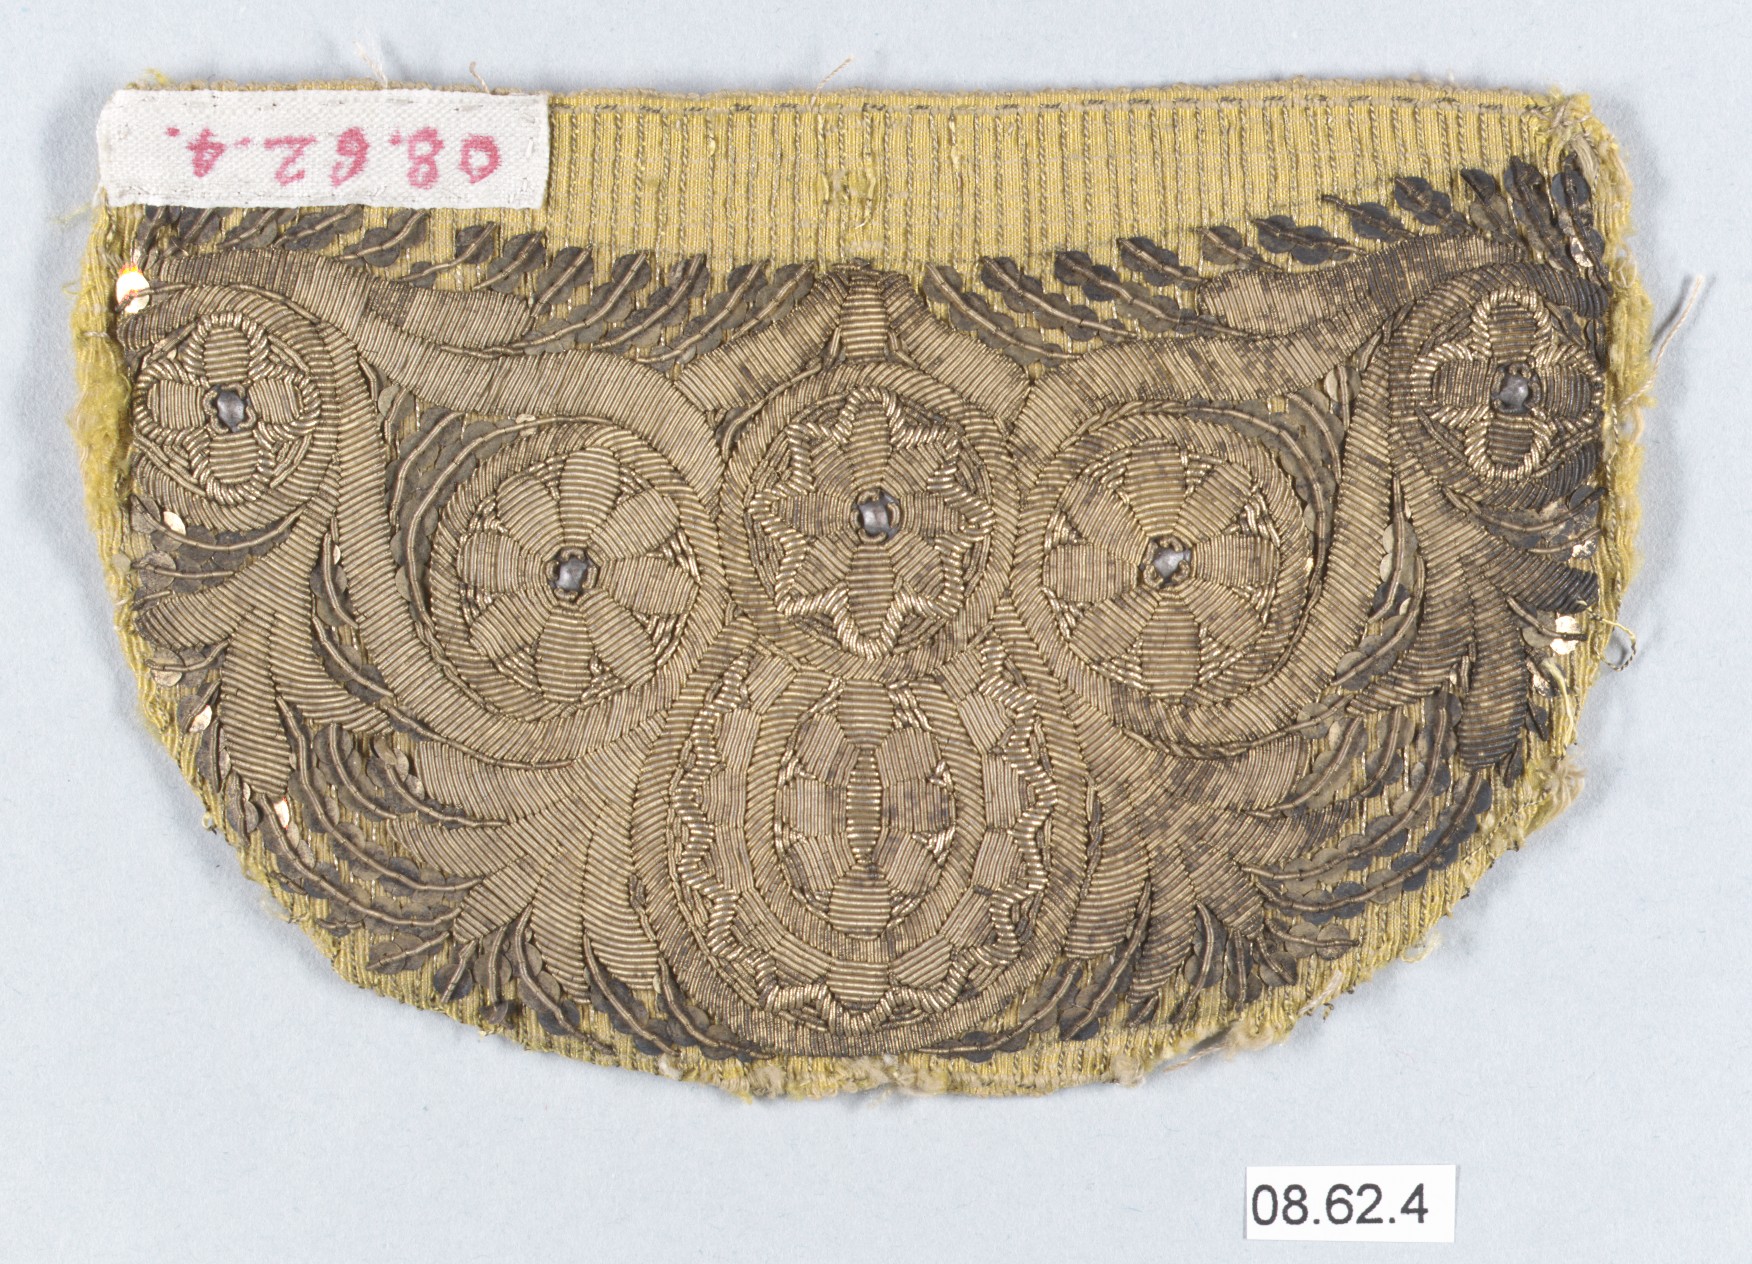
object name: cap crown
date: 1801-1900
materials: metal thread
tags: flowers